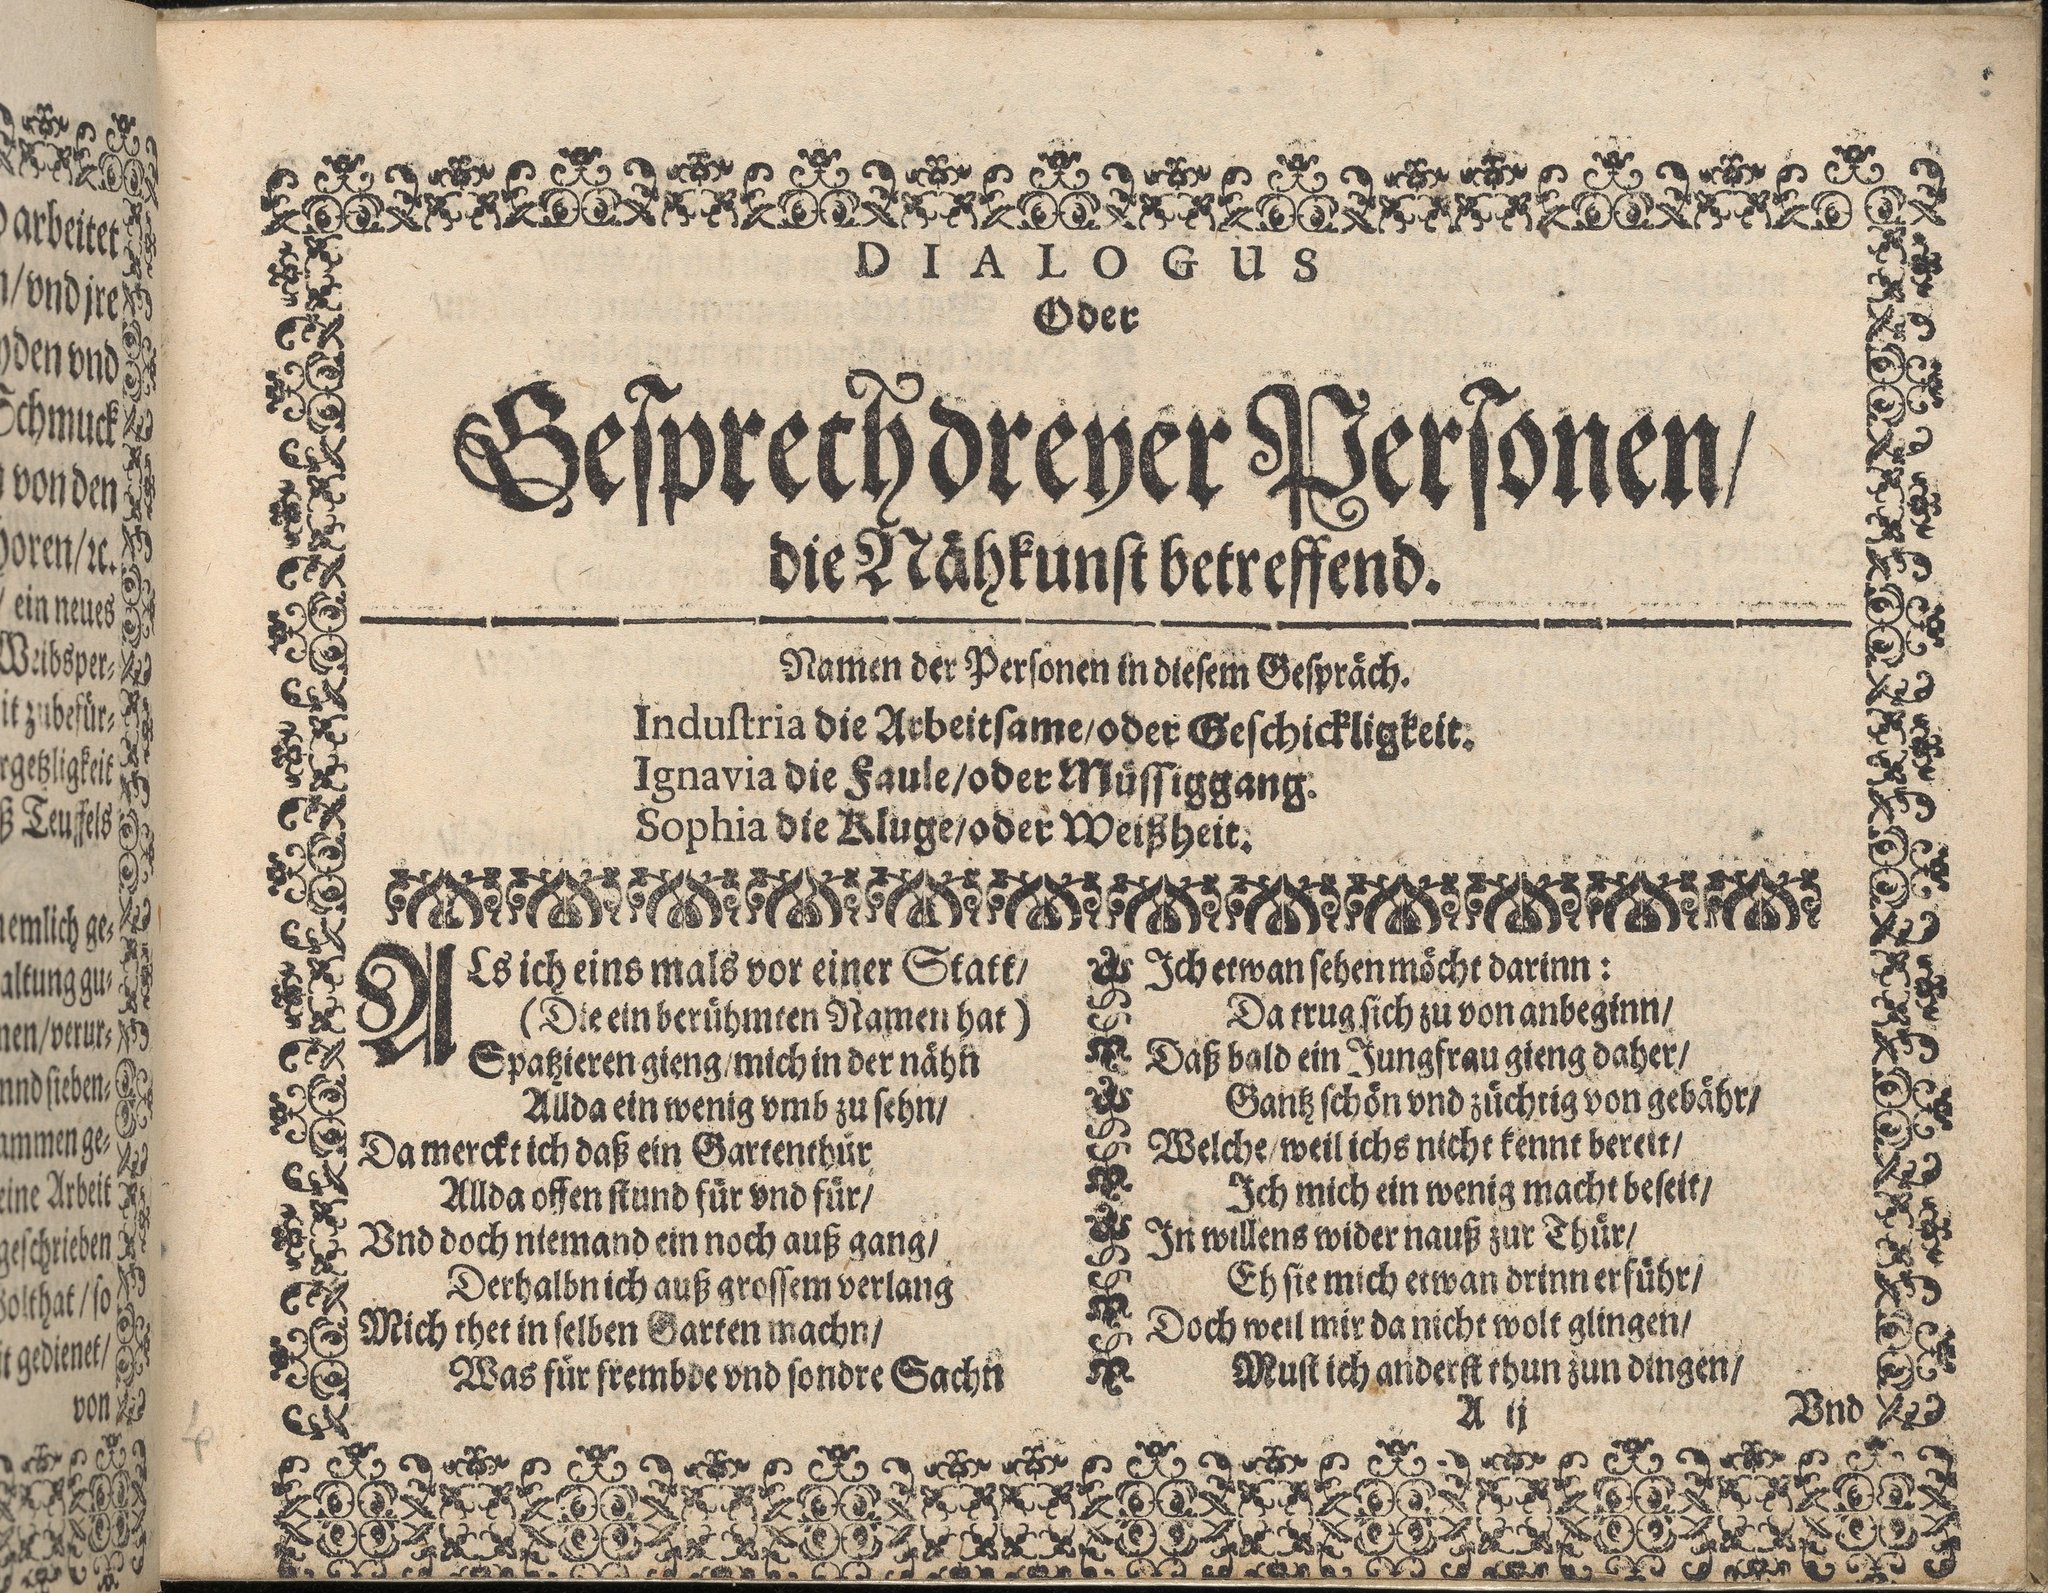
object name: book print ornament architecture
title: Newes Modelbuch in Kupffer (Page 4v)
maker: johann sibmacher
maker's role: artist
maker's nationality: german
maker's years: 1590-1611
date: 1604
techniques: woodcut